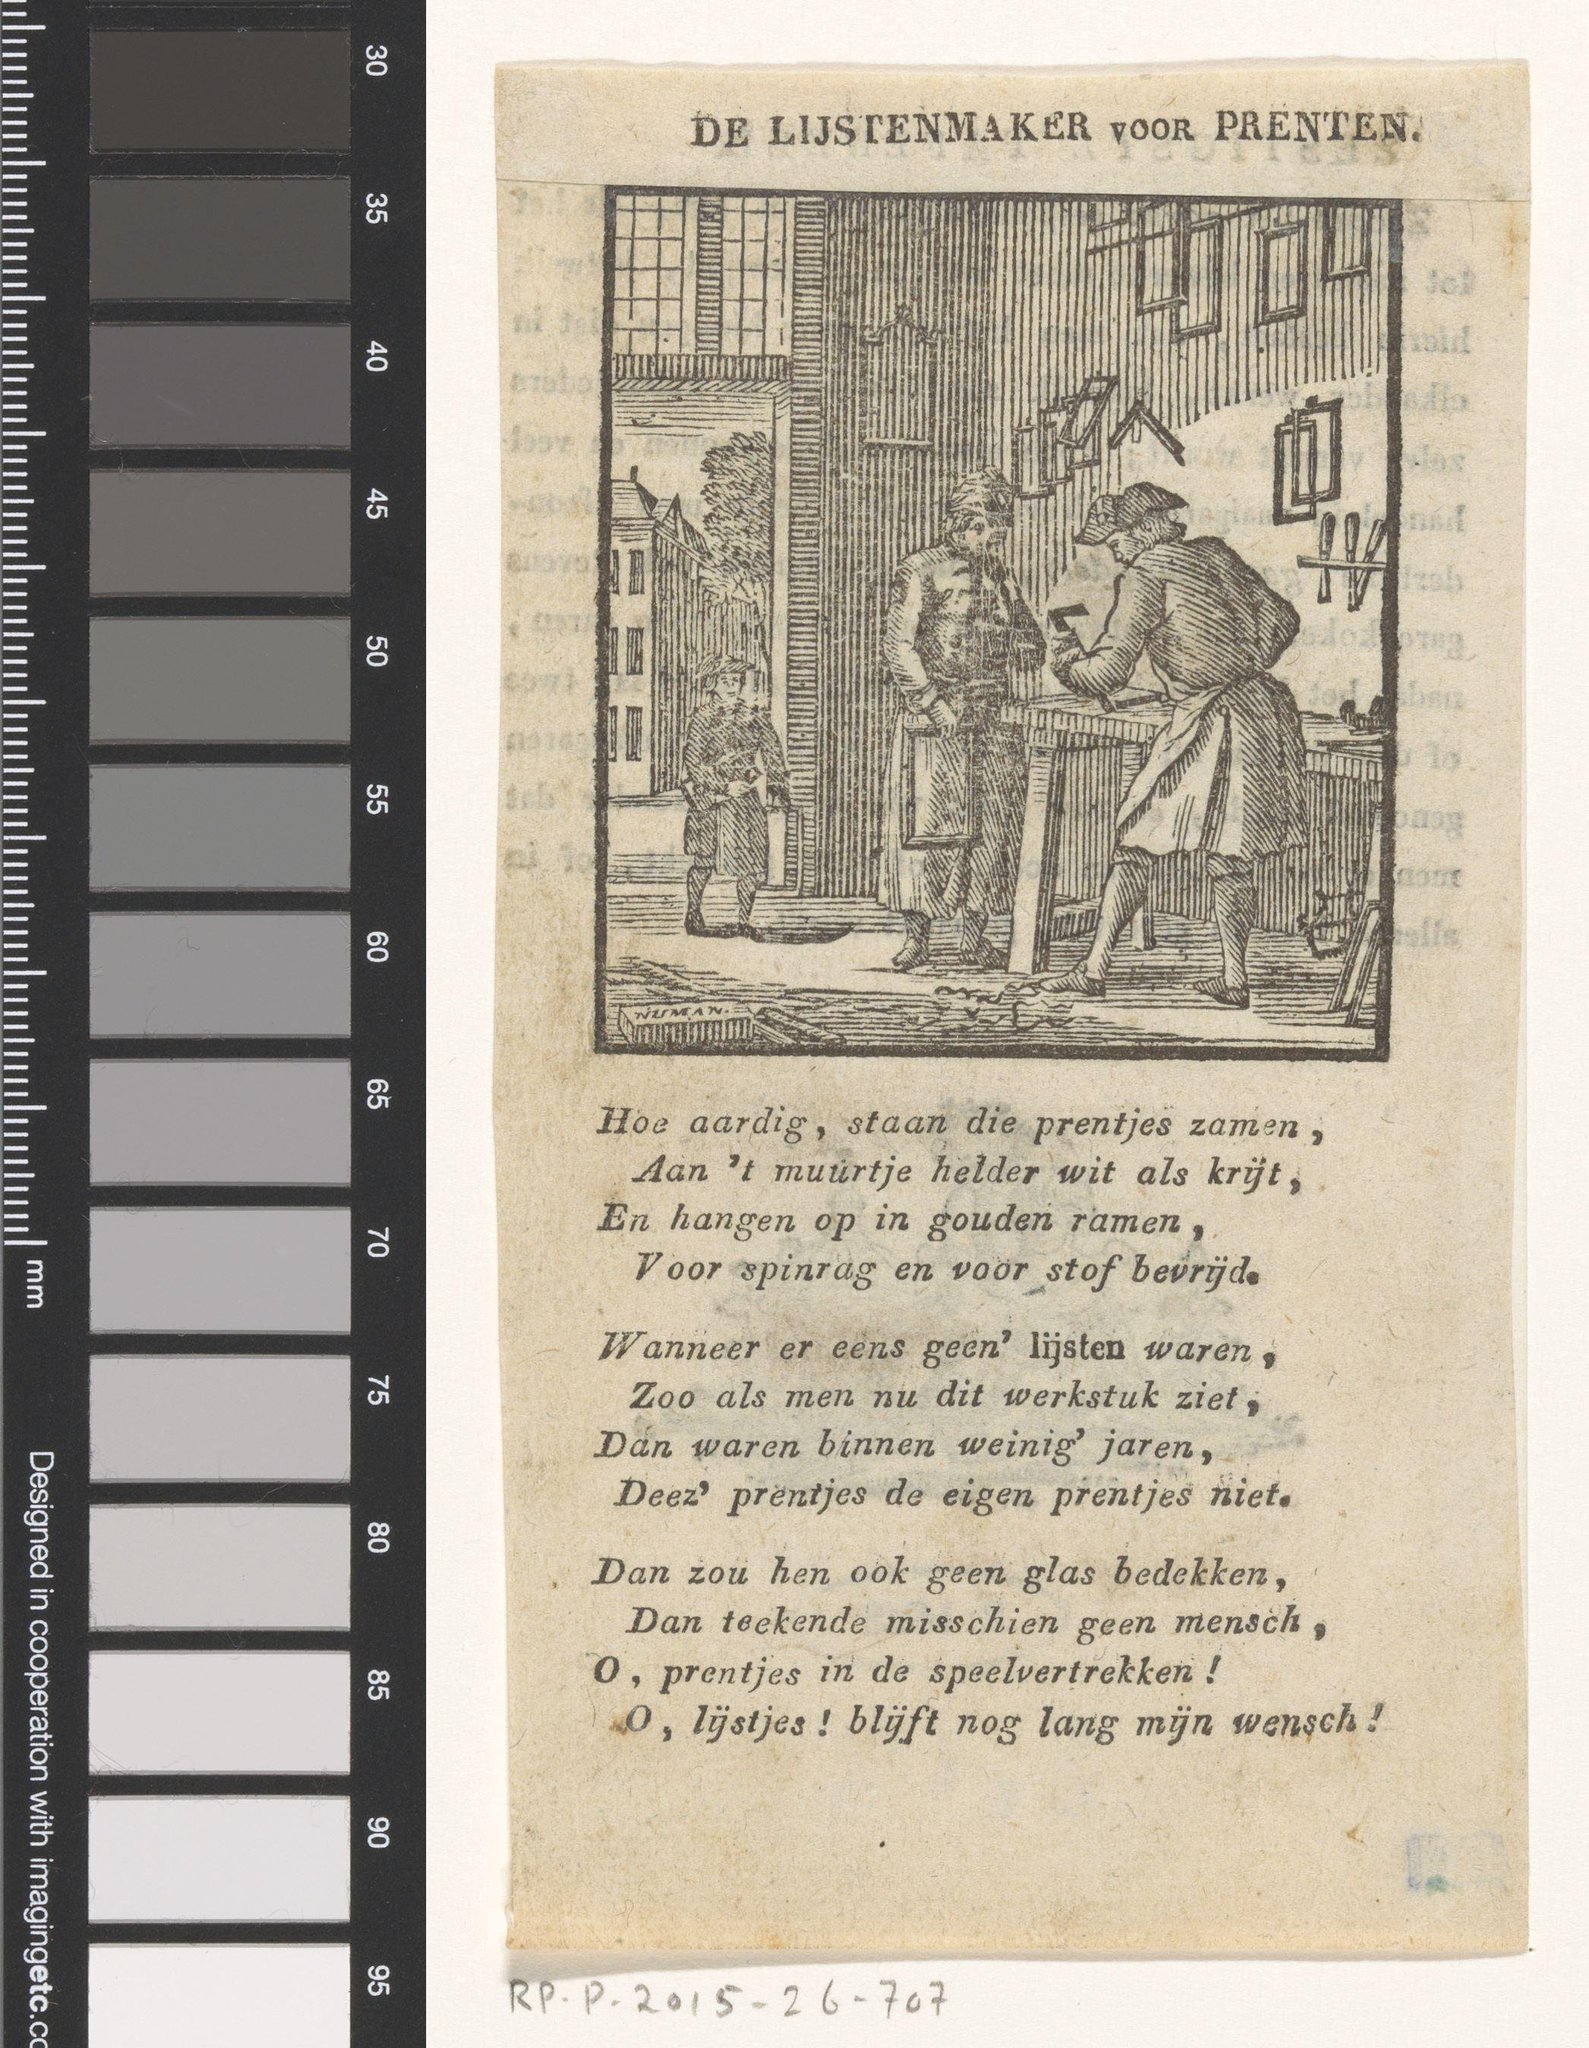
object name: print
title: De lijstenmaker voor prenten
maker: numan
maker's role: print maker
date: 1800-1899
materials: paper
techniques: letterpress printing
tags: handicrafts, craftsman at work, frame of painting, etc.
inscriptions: collector's mark: Lugt 2228, collector's mark: Lugt 4780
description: Waarschijnlijk gebruikt als boekillustratie.